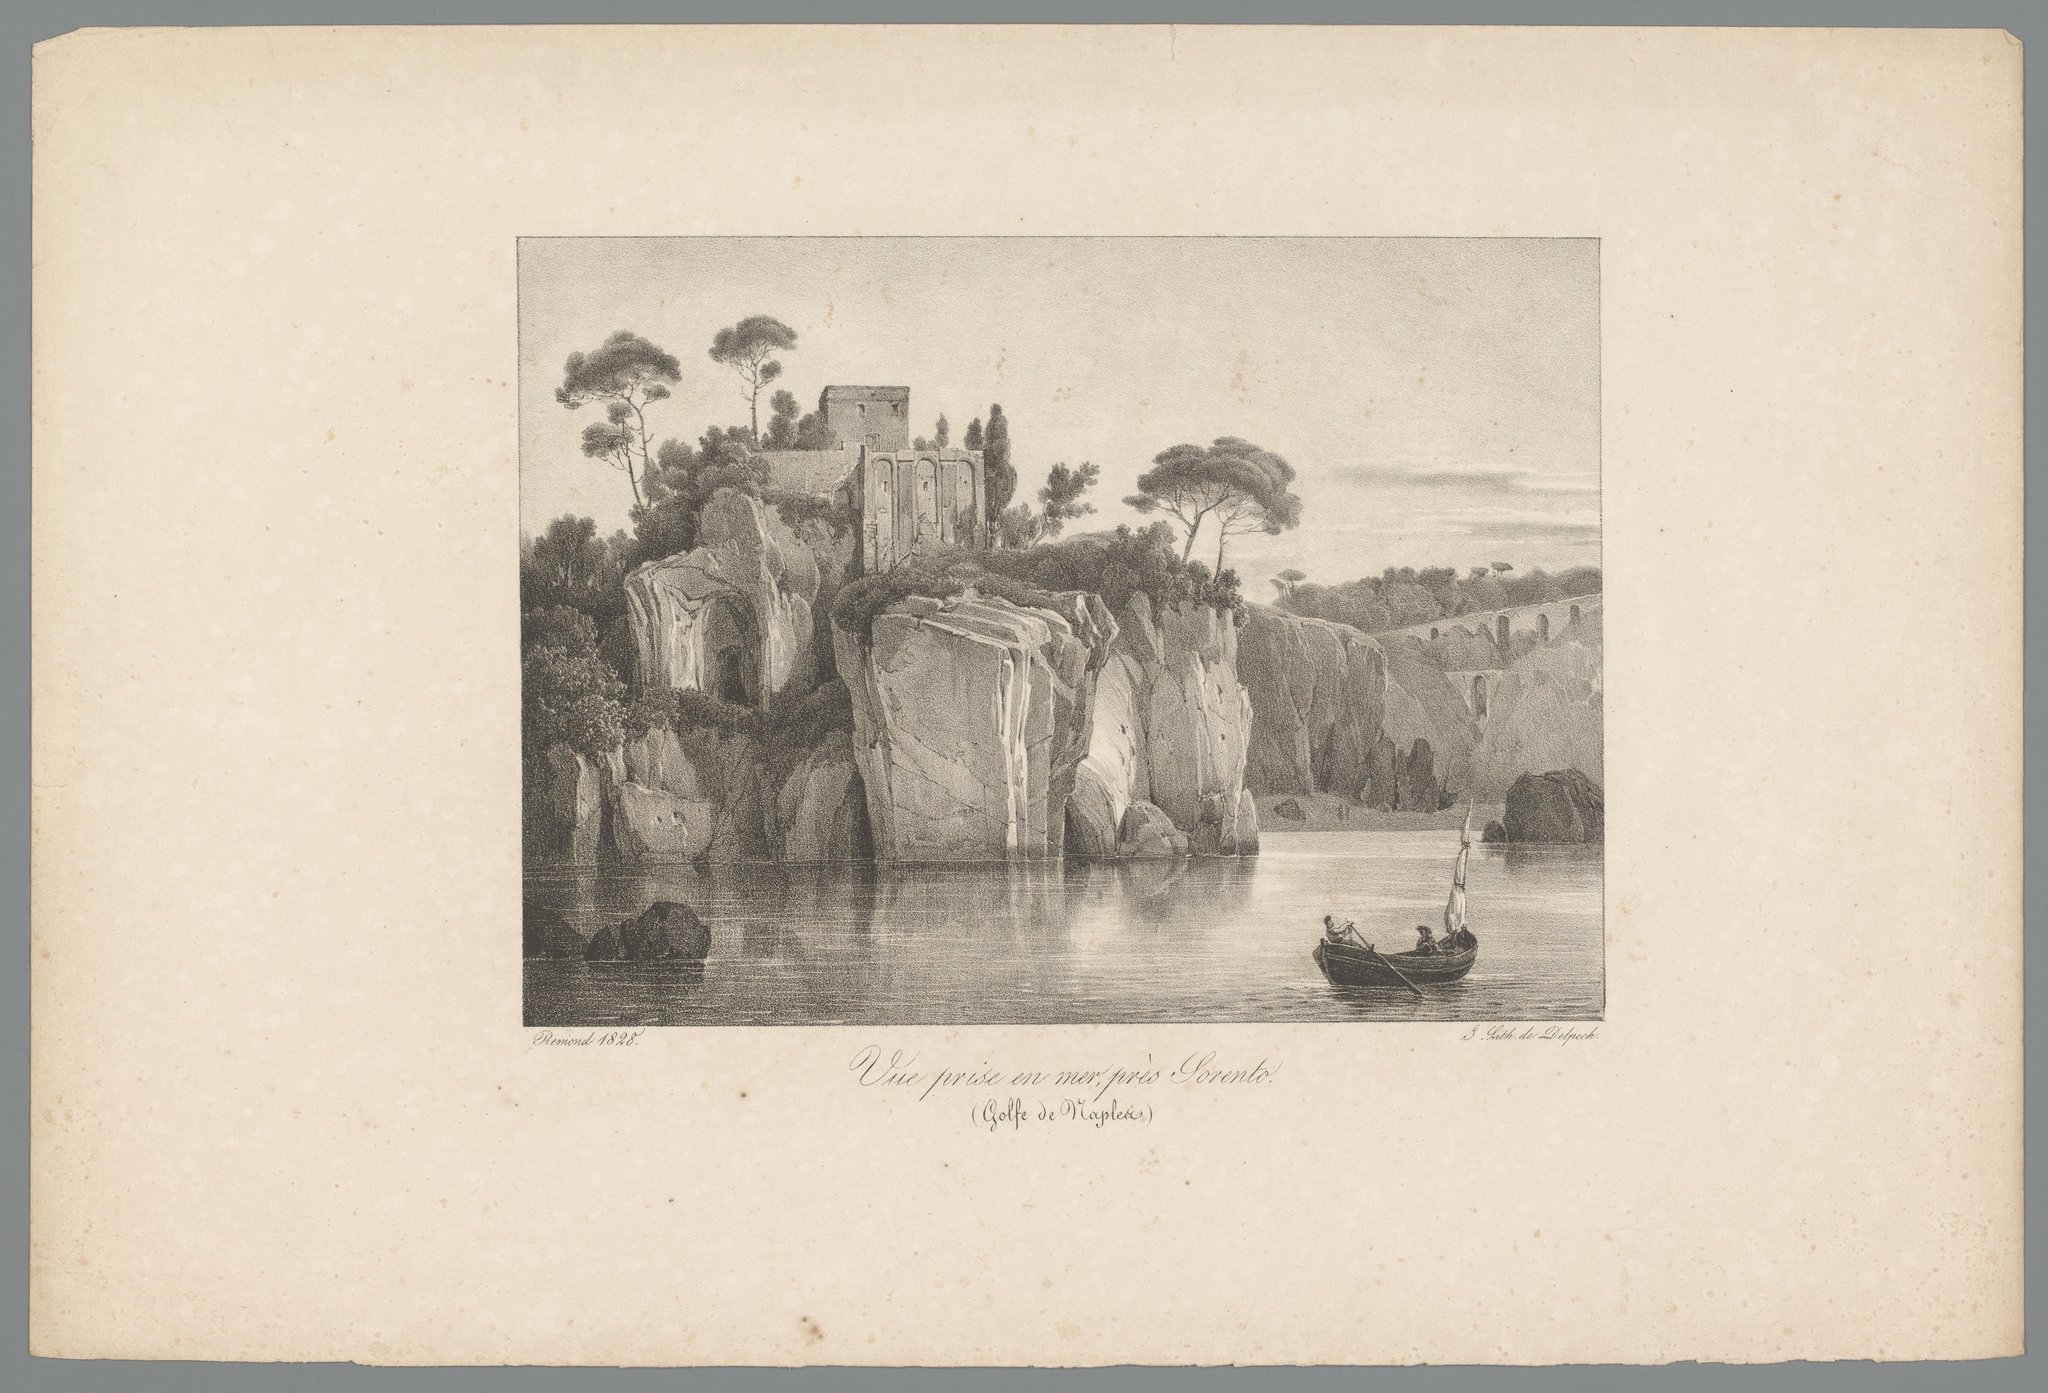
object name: print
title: Gezichten van Italië door Charles Rémond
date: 1828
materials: paper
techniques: lithograph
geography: paris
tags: rock-formations, sea, sorrento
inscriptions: collector's mark: Lugt 2228